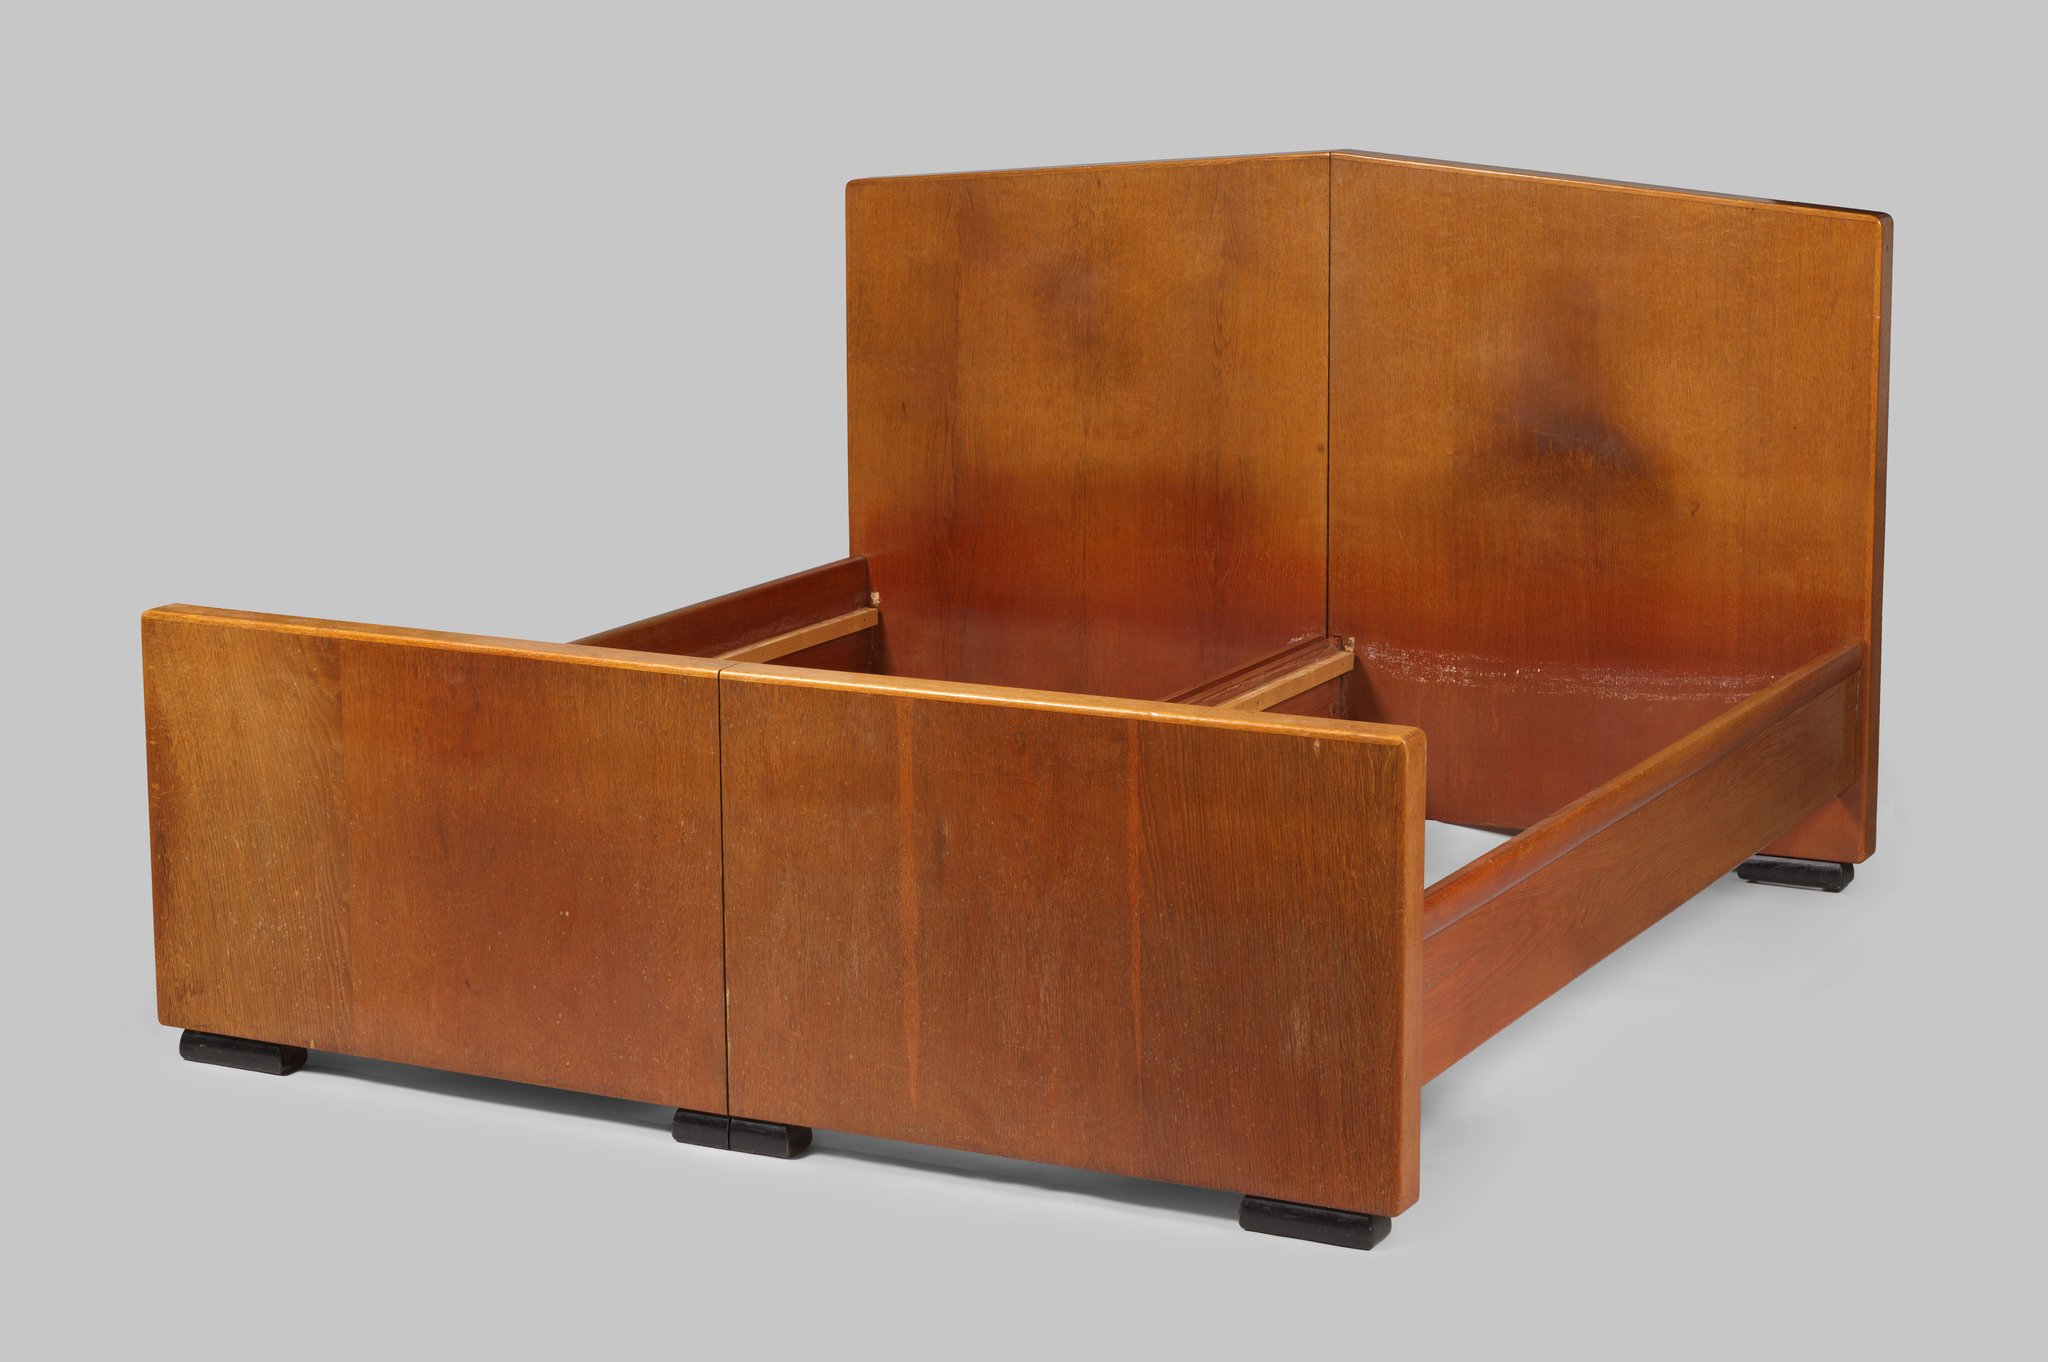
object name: bed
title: Onderdeel van een Lits-jumeaux.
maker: piet l. kramer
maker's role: architect, interieurontwerper, meubelontwerper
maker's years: 1881-1961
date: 1920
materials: wood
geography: netherlands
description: Lits-jumeaux van eiken- en grenenhout en zwart getint without. Ontwerp P. Kramer. Ca. 1920. Ligmeubel.